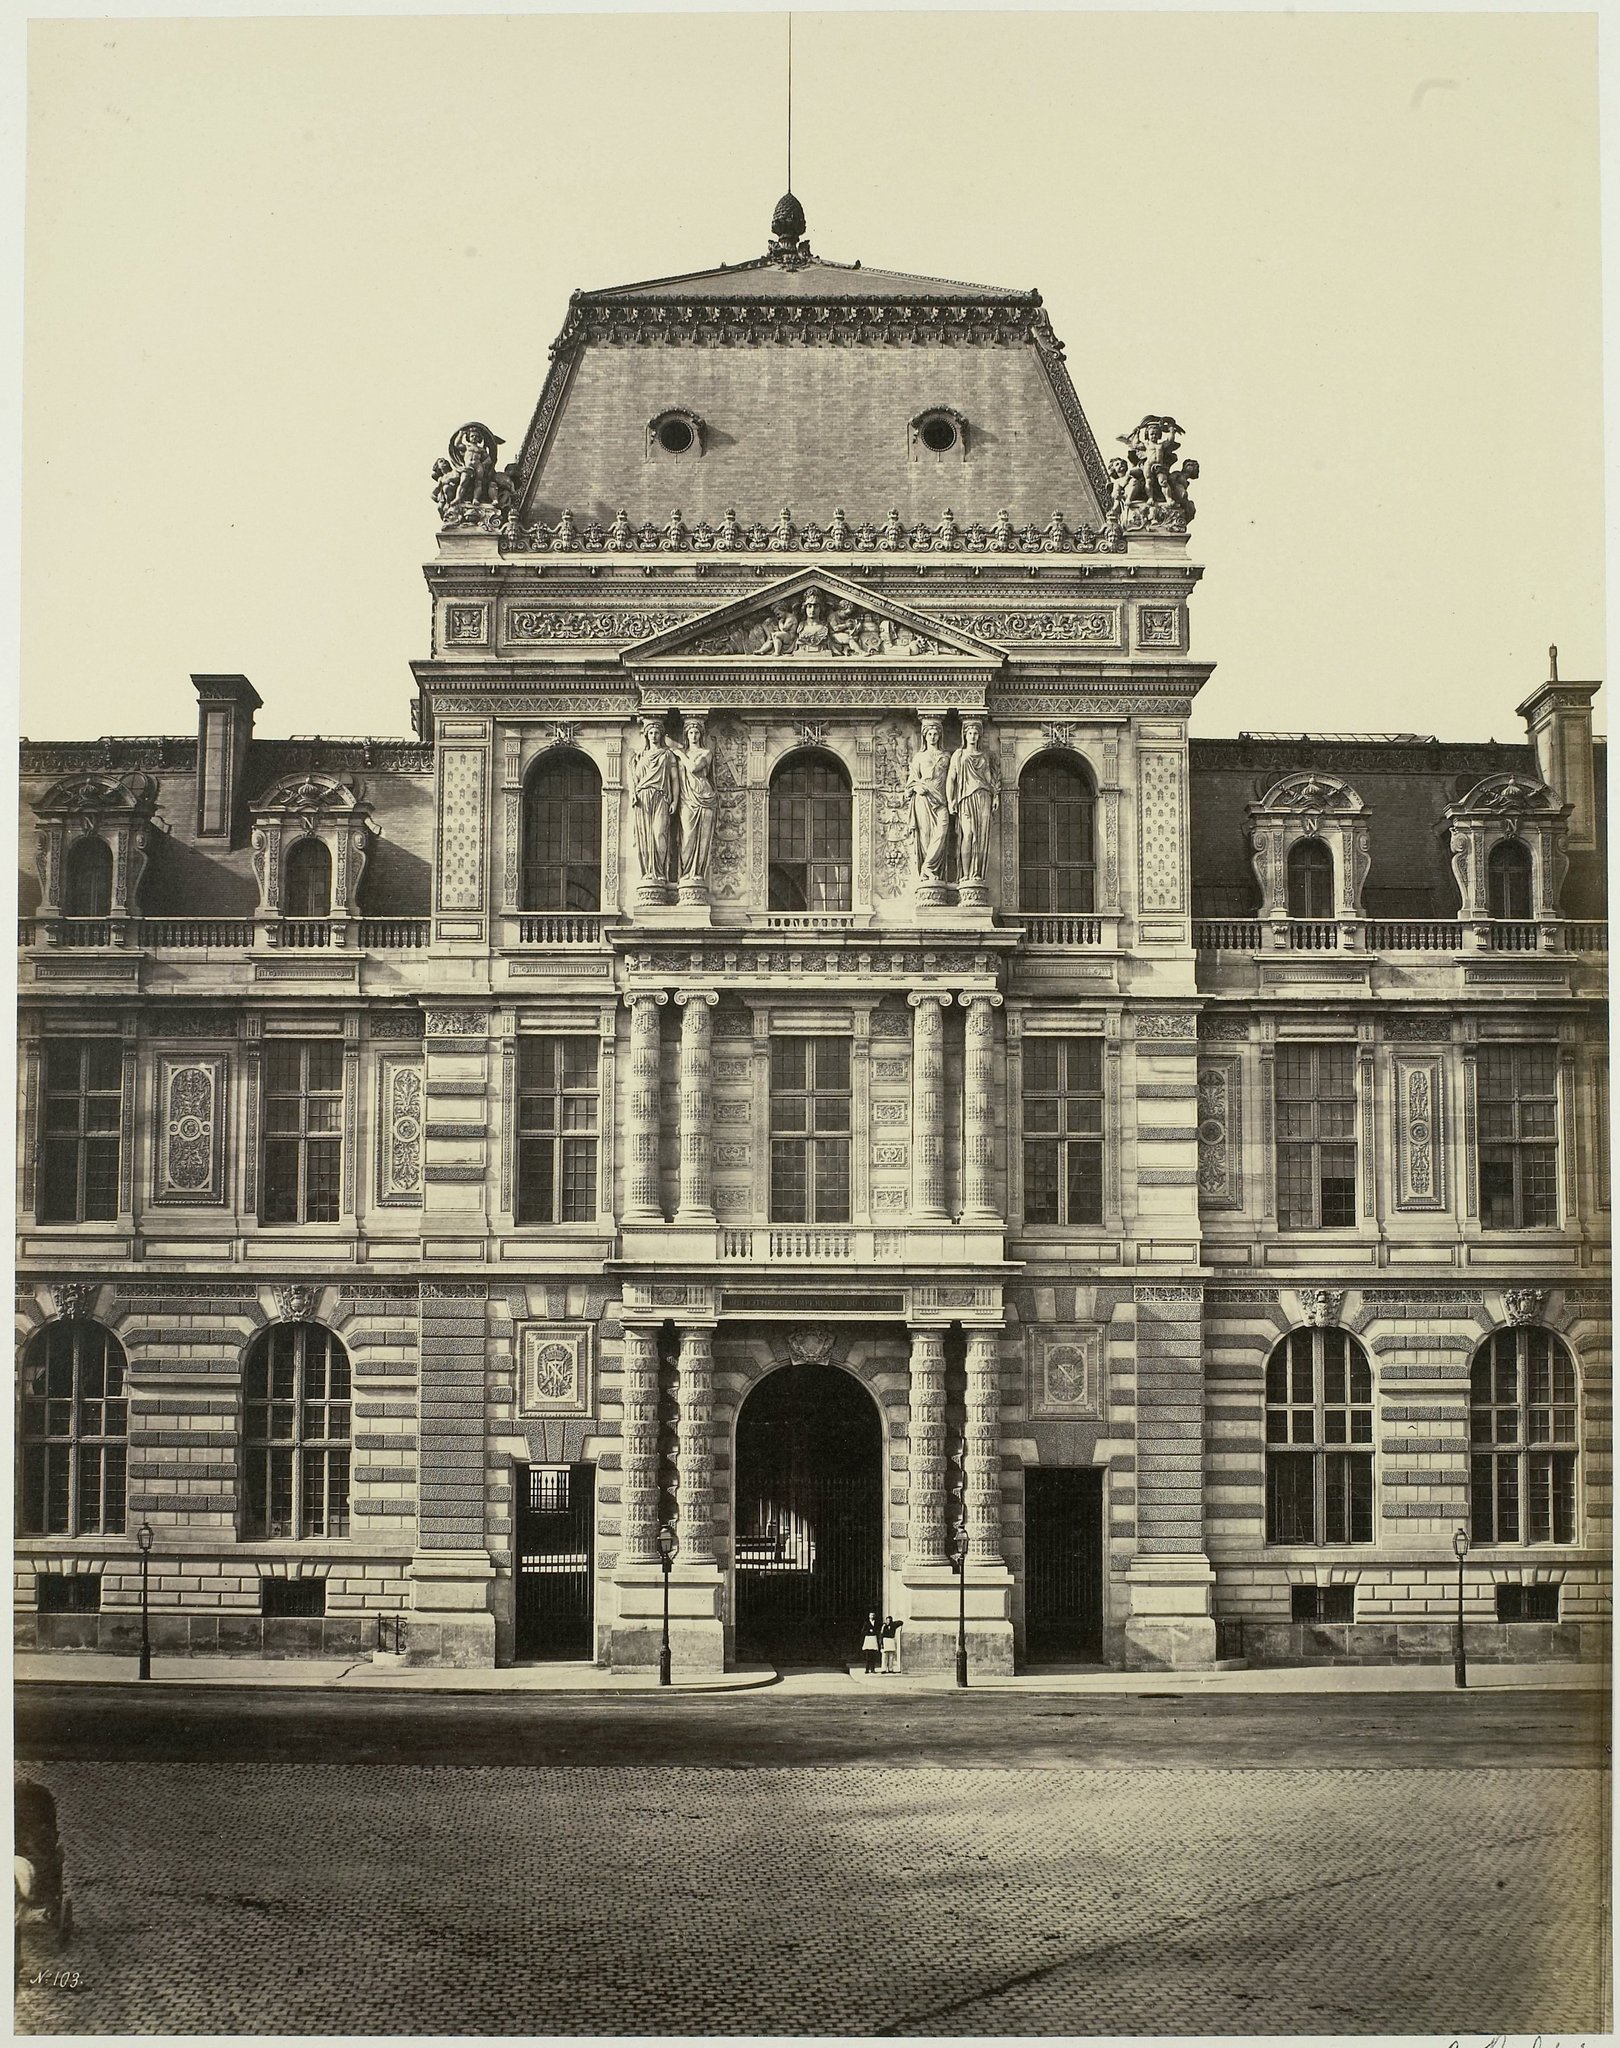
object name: photograph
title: Pavillon de la Bibliothèque Impériale in Paris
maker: édouard denis baldus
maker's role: fotograaf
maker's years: 1813-1889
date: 1856-1857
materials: cardboard, photographic support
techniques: albumen print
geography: france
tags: musée du louvre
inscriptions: inscription: ‘New Louvre-Bibliothèque Imperiale. Paris/ ... Un Place du Palais-Royal’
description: Photography as a free and independent medium hardly existed in the 19th century: many of the photographs from this time were taken on commission for a specific purpose. Photographers such as Baldus and Marville, now considered undisputed great masters of 19th-century photography, rarely made non-commissioned work. Around 1855 Baldus recorded the massive rebuilding campaign of the Louvre.